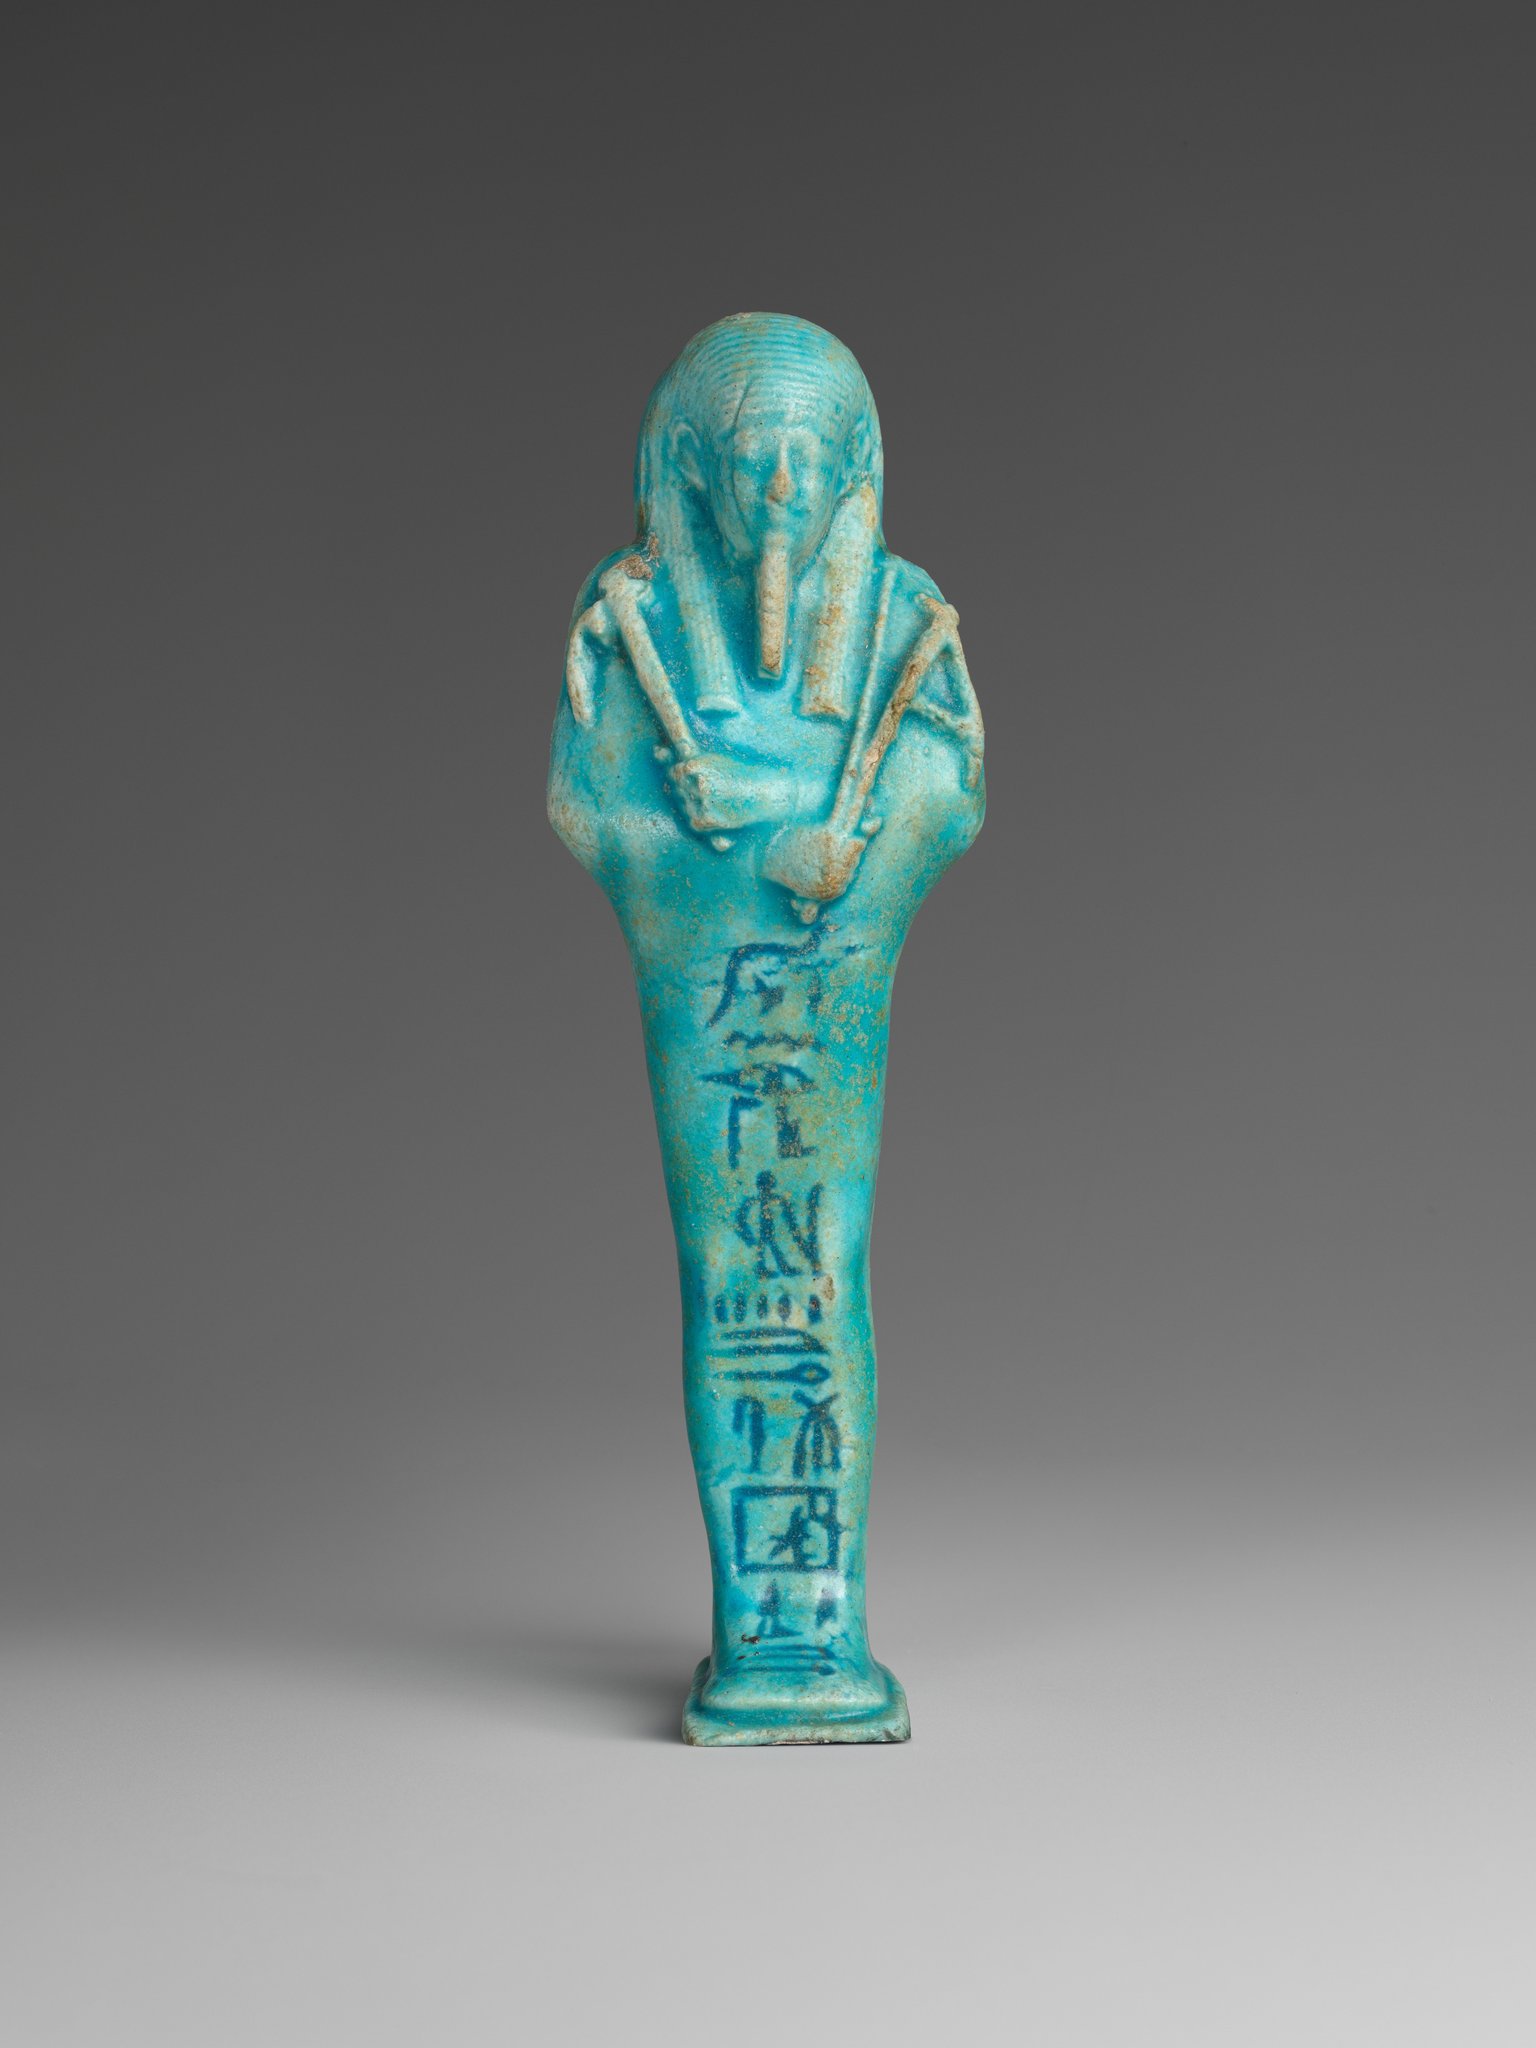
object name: shabti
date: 664-343 BCE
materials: faience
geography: egypt